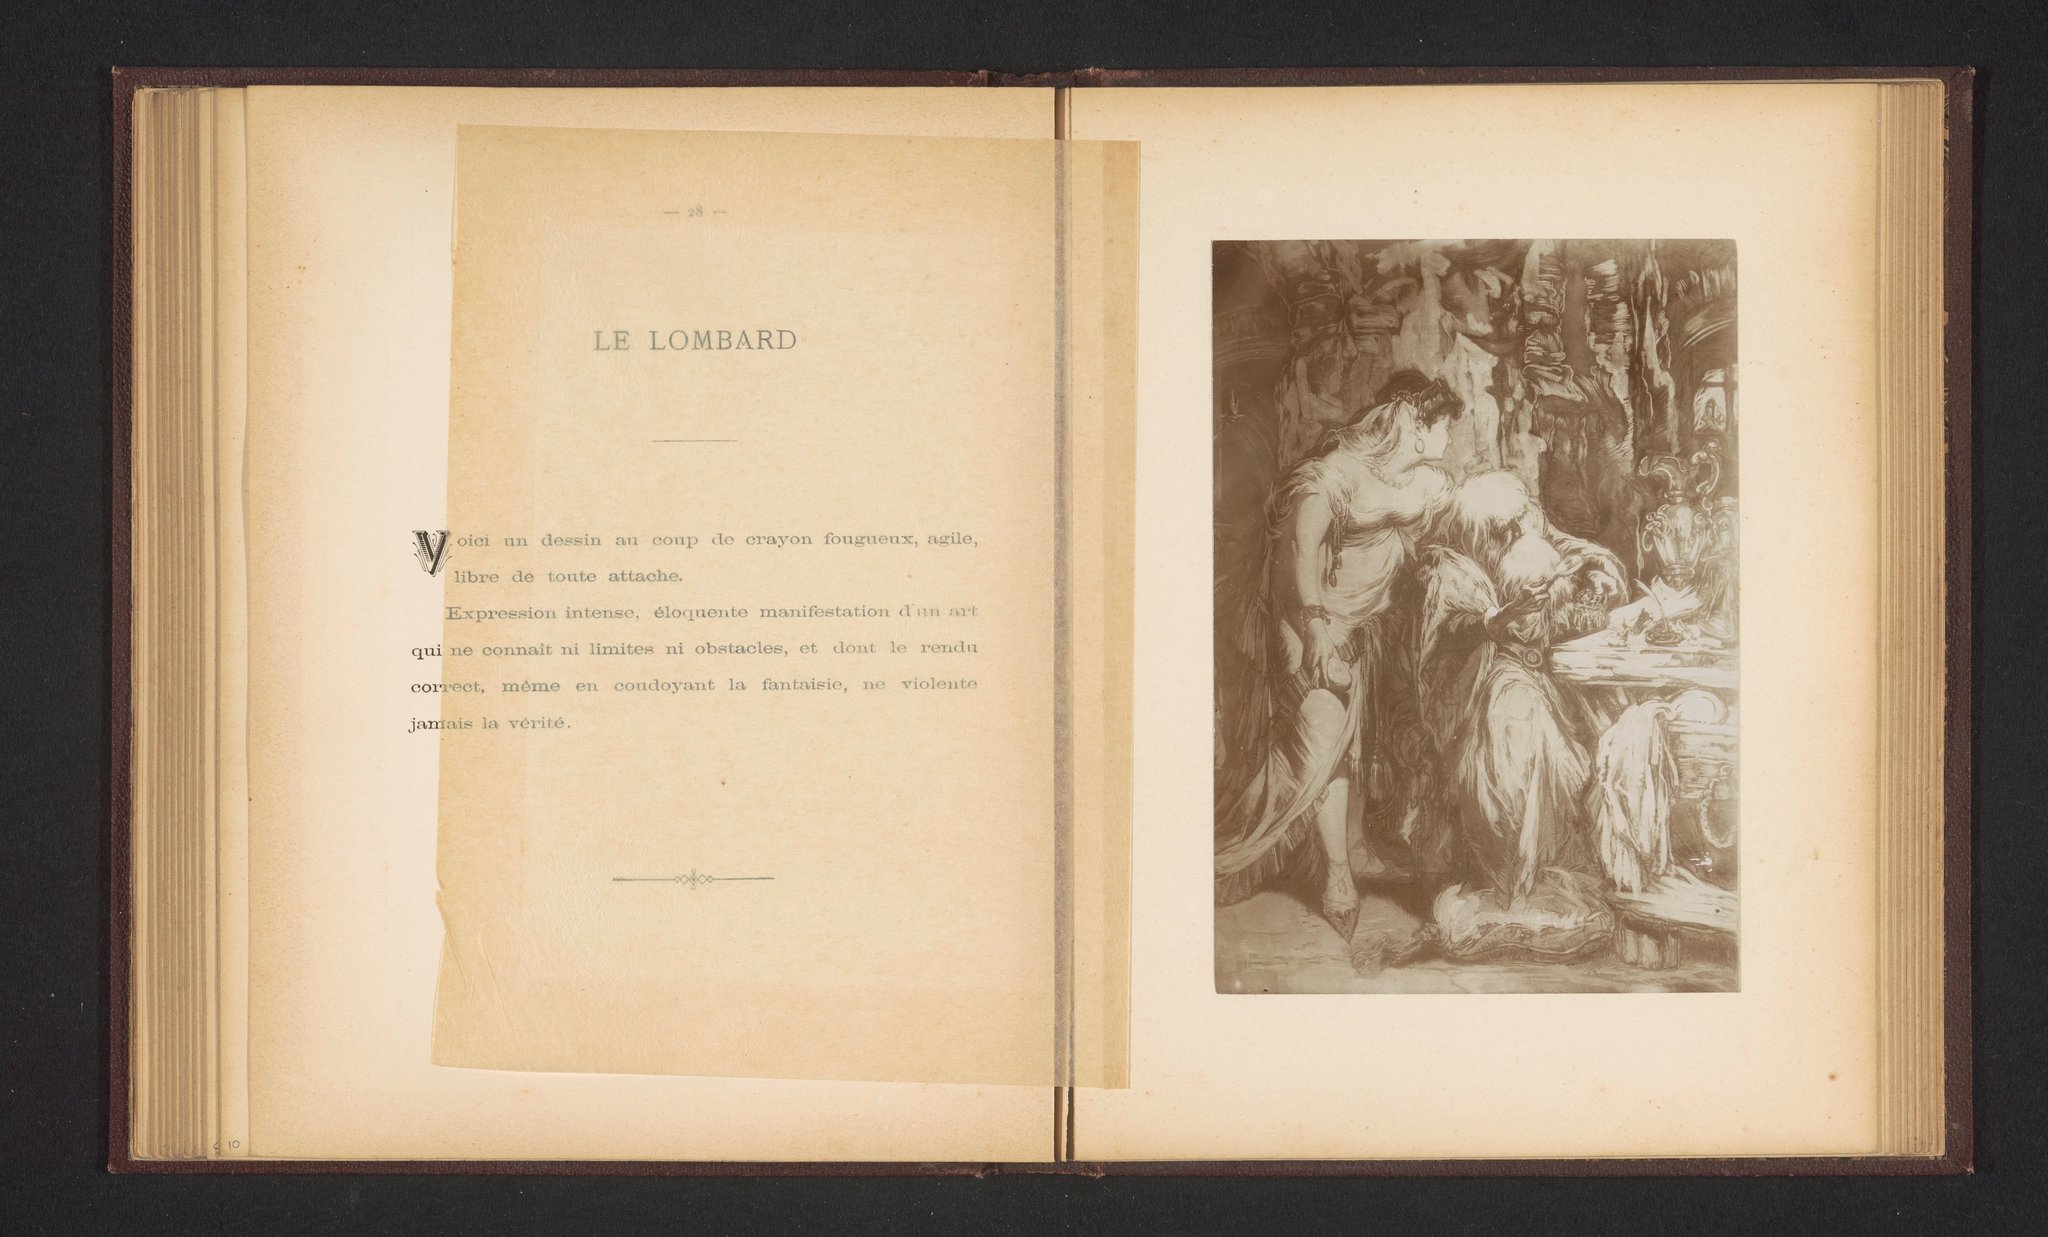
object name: reproduction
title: Fotoreproductie van een schilderij van een oude man aan tafel, met achter hem een jonge vrouw door Willem Linnig (II)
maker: alexandre van antro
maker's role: painter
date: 1891-1896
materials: photographic support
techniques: collodion silver print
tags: adult woman, table, old man